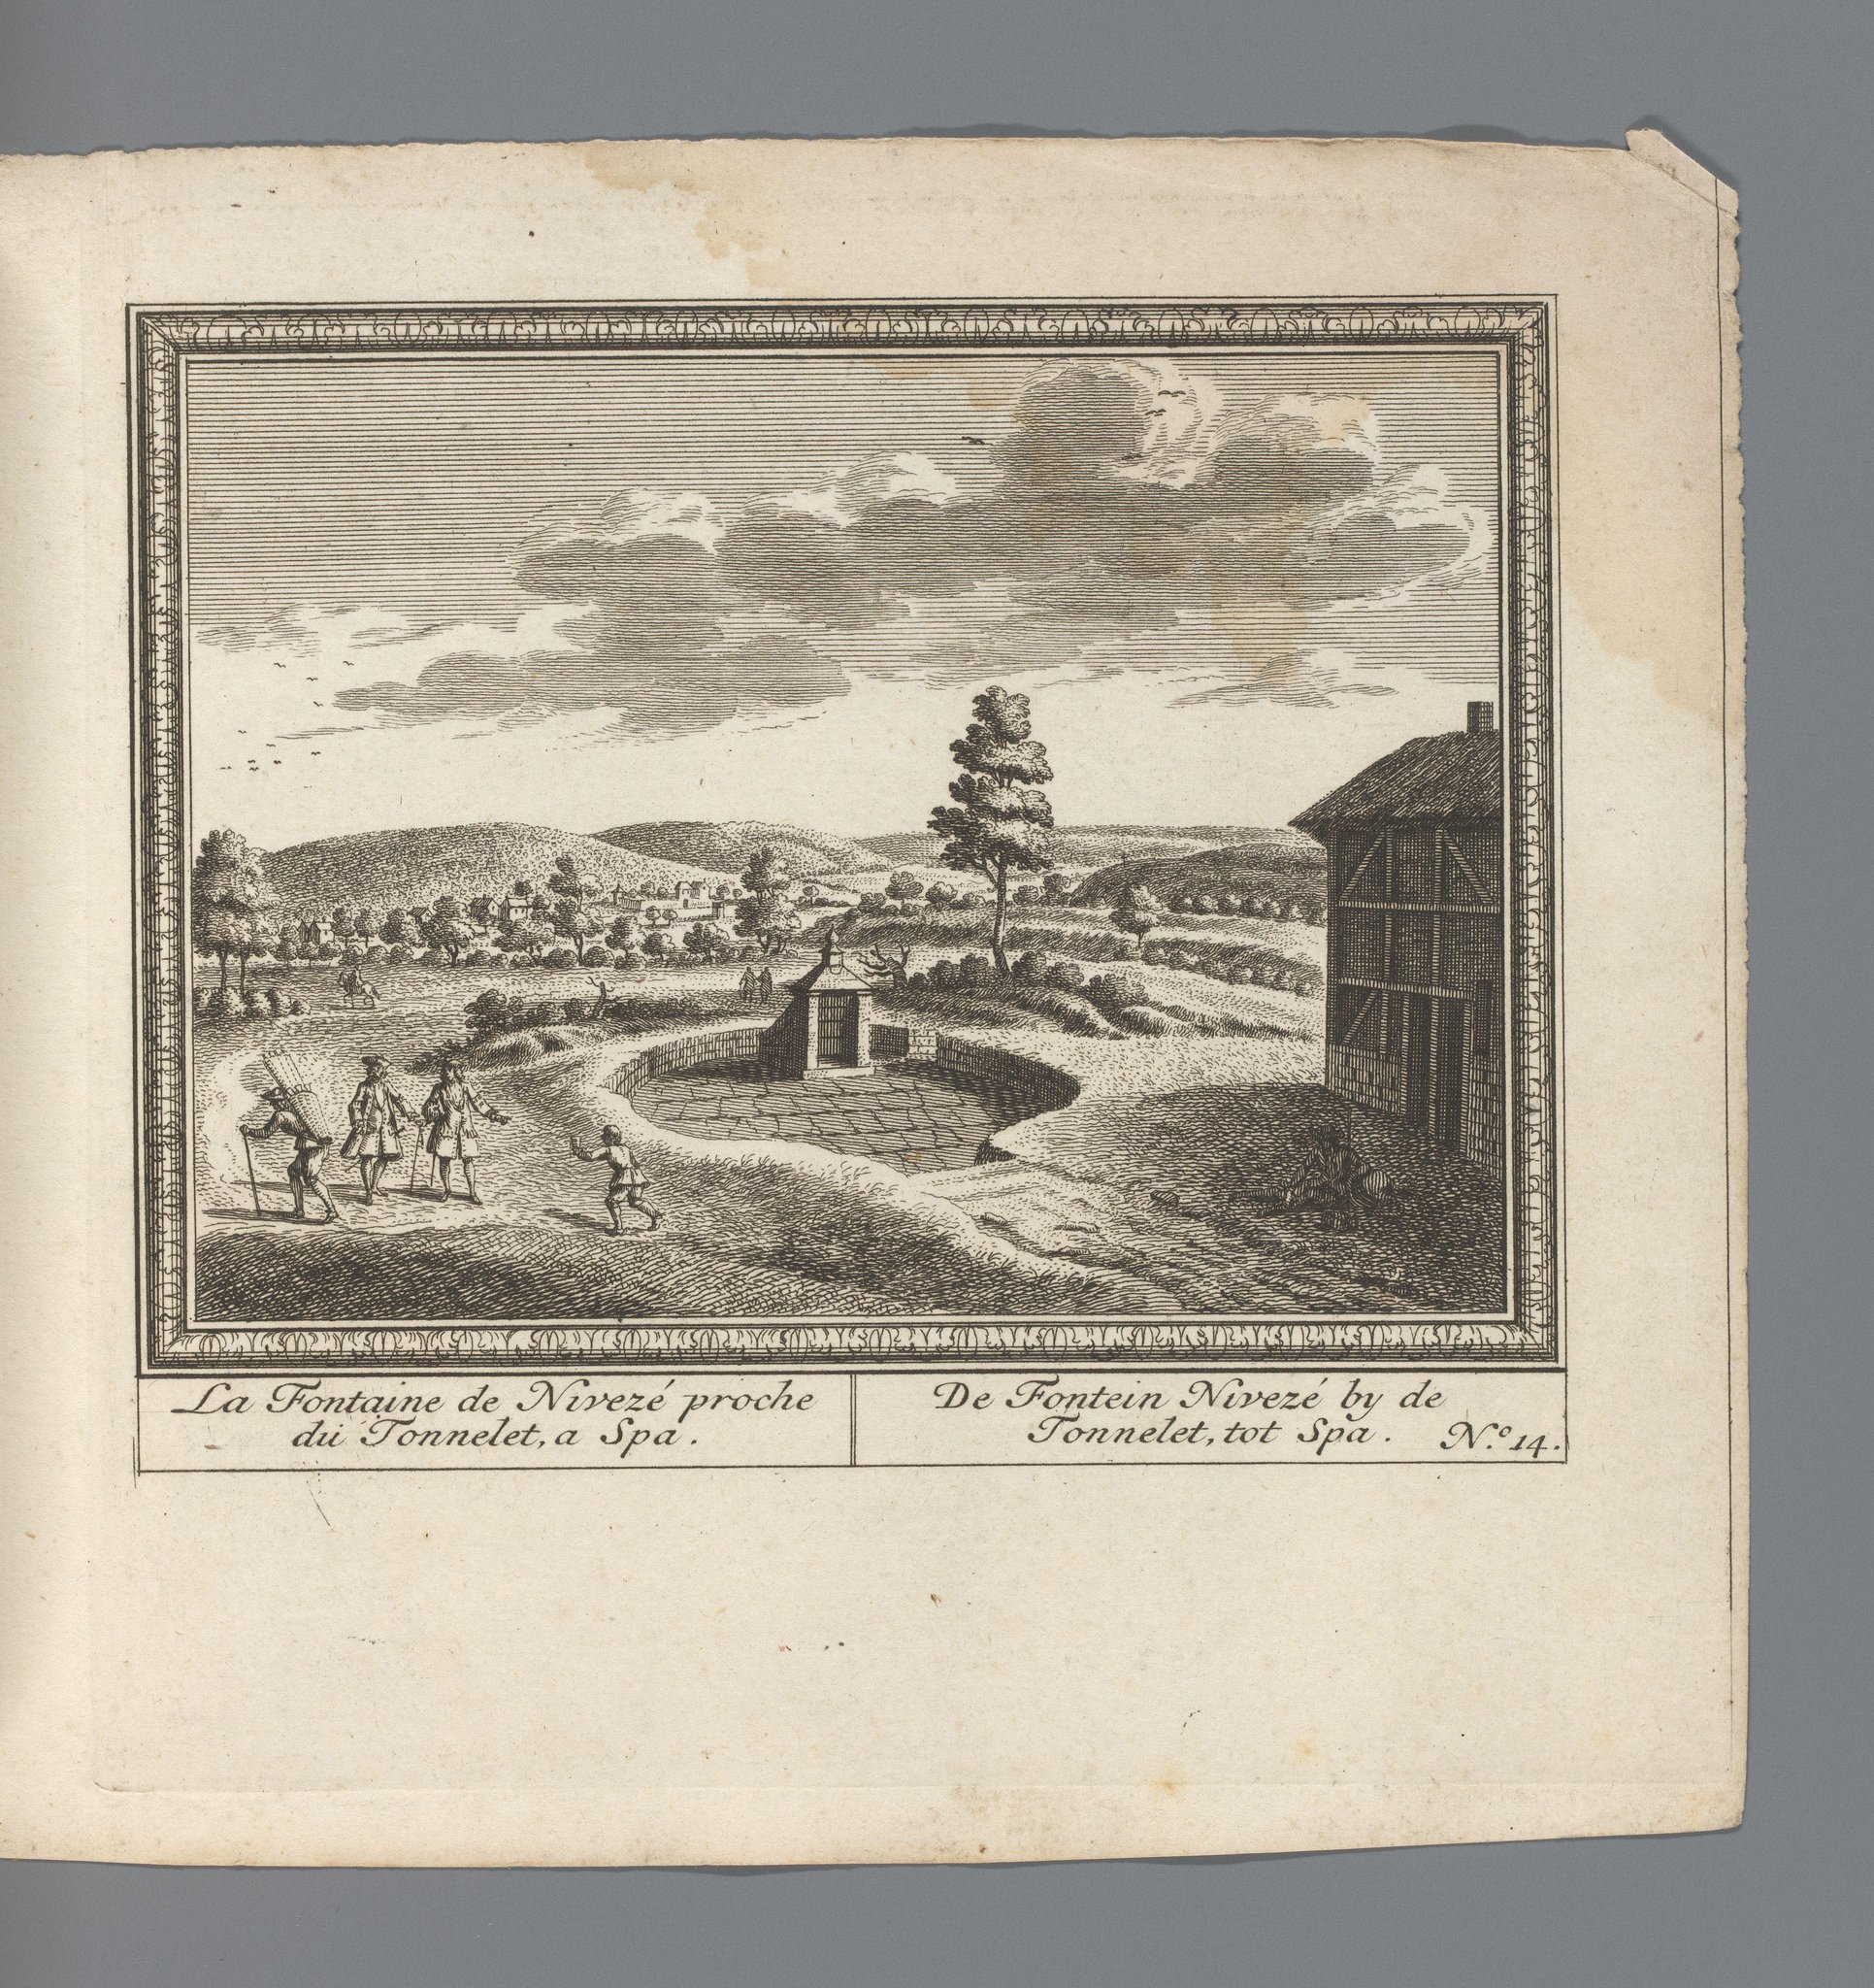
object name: print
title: La fontaine de Nivezé proche du Tonnelet, a Spa / De fontein Nivezé by de Tonnelet, tot Spa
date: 1734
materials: paper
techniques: etching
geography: amsterdam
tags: city-view in general; 'veduta', mineral water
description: Deze serie prenten is gebruikt in: Pöllnitz, Charles-Louis. Amuseums des eaux de Spa. Ouvrage utile a ceux qui vont boire ces eaux minérales sur les lieux. 2 dln. Amsterdam: Pieter Mortier, 1734. In deze uitgave zijn de prenten echter gevouwen. Mogelijk is deze serie een losse uitgave van de prenten. Er ontbreekt één prent die in het boek is opgenomen (nr. 4), waarop geen landschap is afgebeeld.